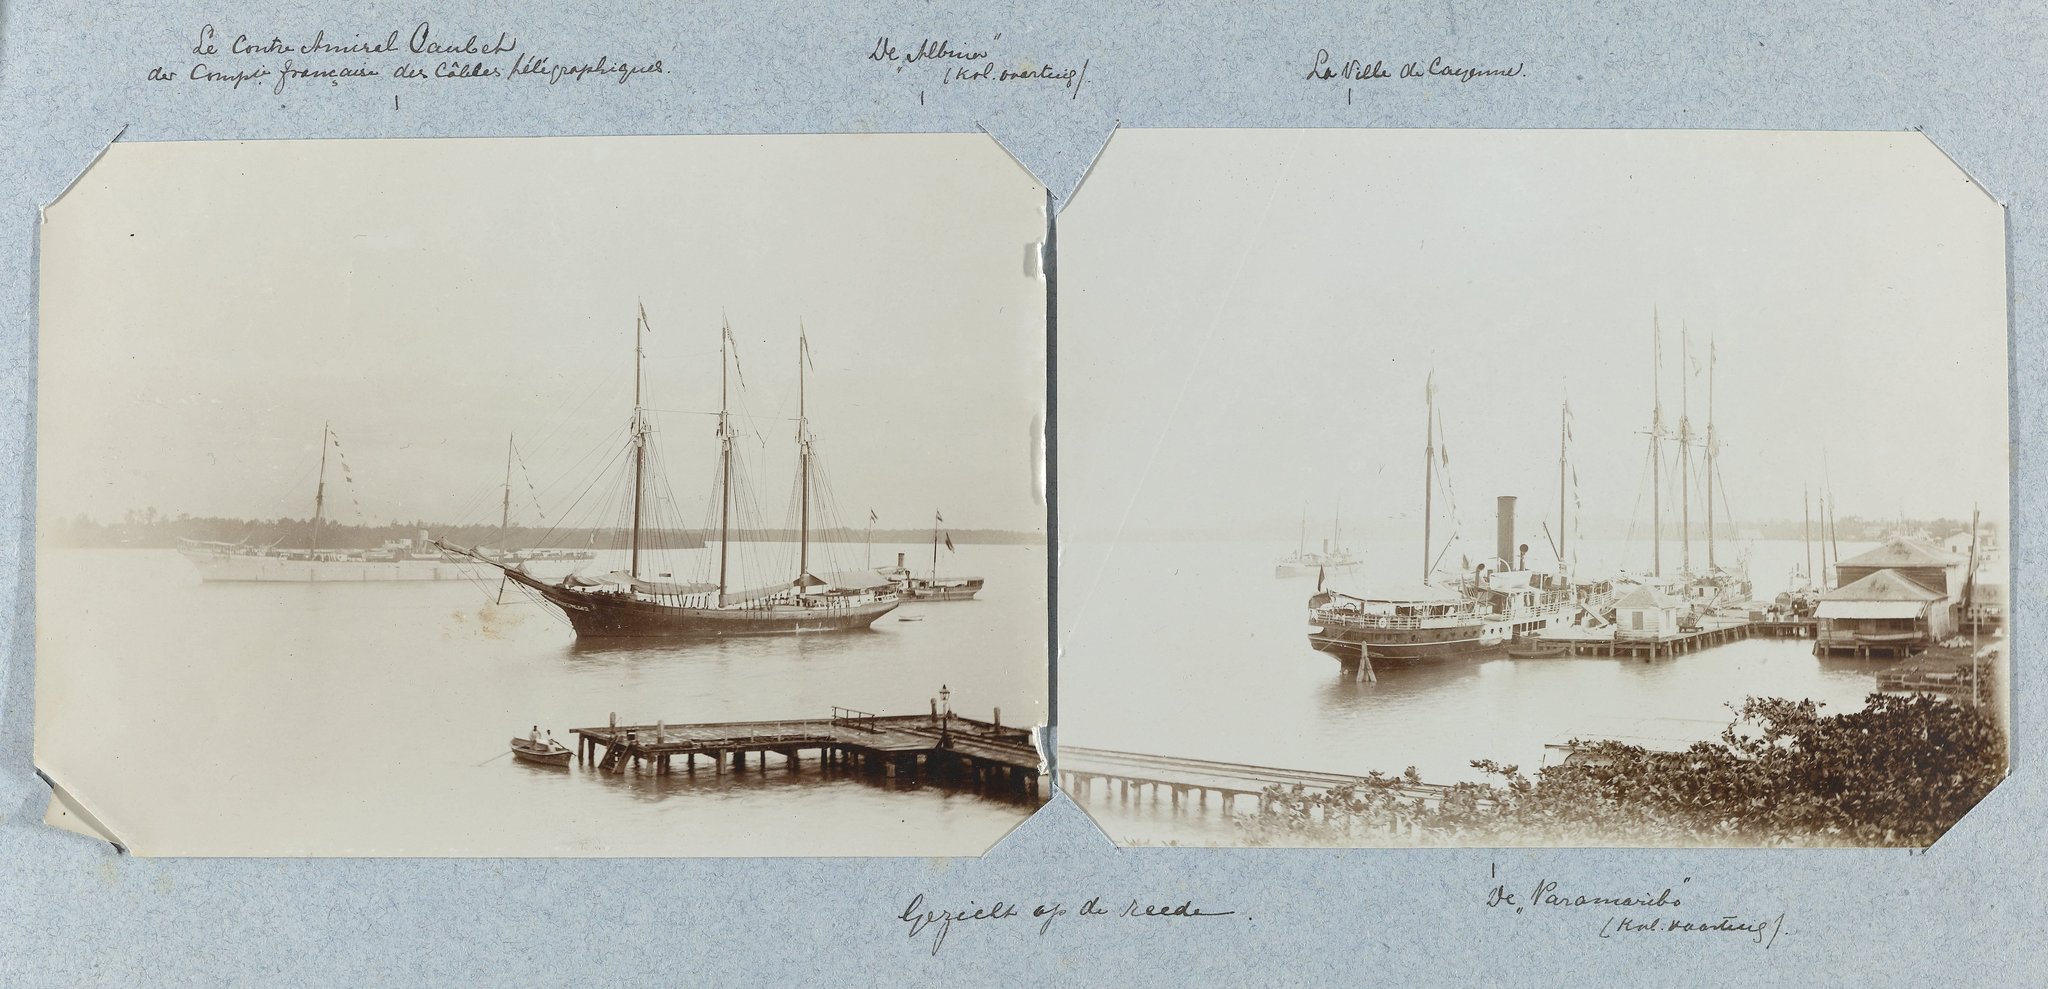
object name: photograph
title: Gezicht op de reede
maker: théodore van lelyveld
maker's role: painter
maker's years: 1867-1954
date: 1895-1898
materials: photographic support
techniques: collodion silver print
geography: suriname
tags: pier, quay, wharf, ship in the roads, roadstead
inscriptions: inscription: ‘Gezicht op de reede. / Le contre Amiral Courbet der Comp.ie Française des Câbles télégraphiques / De "Albina" (kol. vaartuig) / La Ville de Cayenne / De "Paramaribo" (kol. vaartuig)’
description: Gezicht op de rede van Paramaribo. Verschillende schepen liggen voor anker, waaronder de Albina, La Ville de Cayenne en de Paramaribo. Panorama samengesteld uit twee aan elkaar geplakte fotoafdrukken. Fotoafdruk in een fotoalbum van Théodore van Lelyveld over Suriname uit 1895-1898.